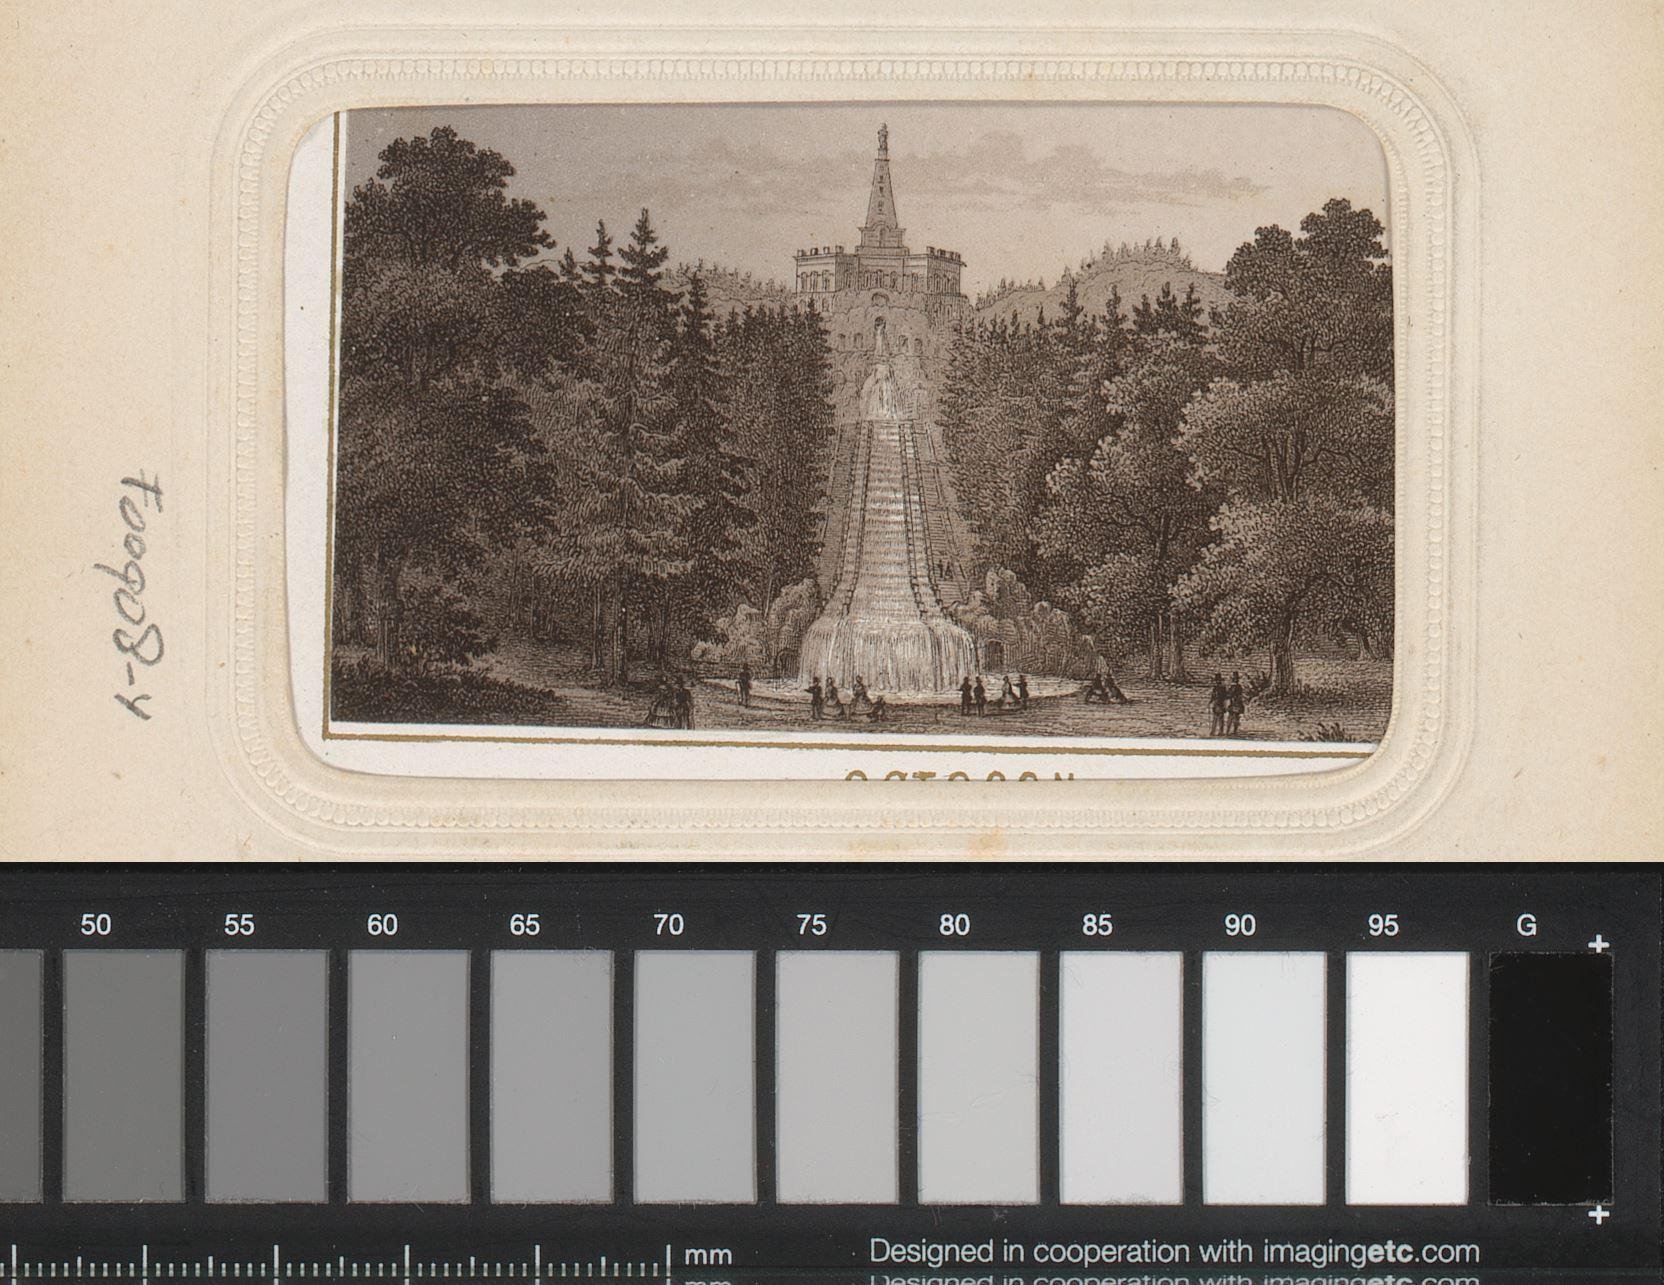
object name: photograph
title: Fotoreproductie van een prent van het Herculesmonument met de grote cascaden bij Schloss Wilhelmshöhe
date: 1860-1885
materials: cardboard, photographic support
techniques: collodion silver print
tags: trees, garden cascade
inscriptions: annotation: ‘Willemshöhe’, inscription: ‘Cassel [...] Wollemhöhe’